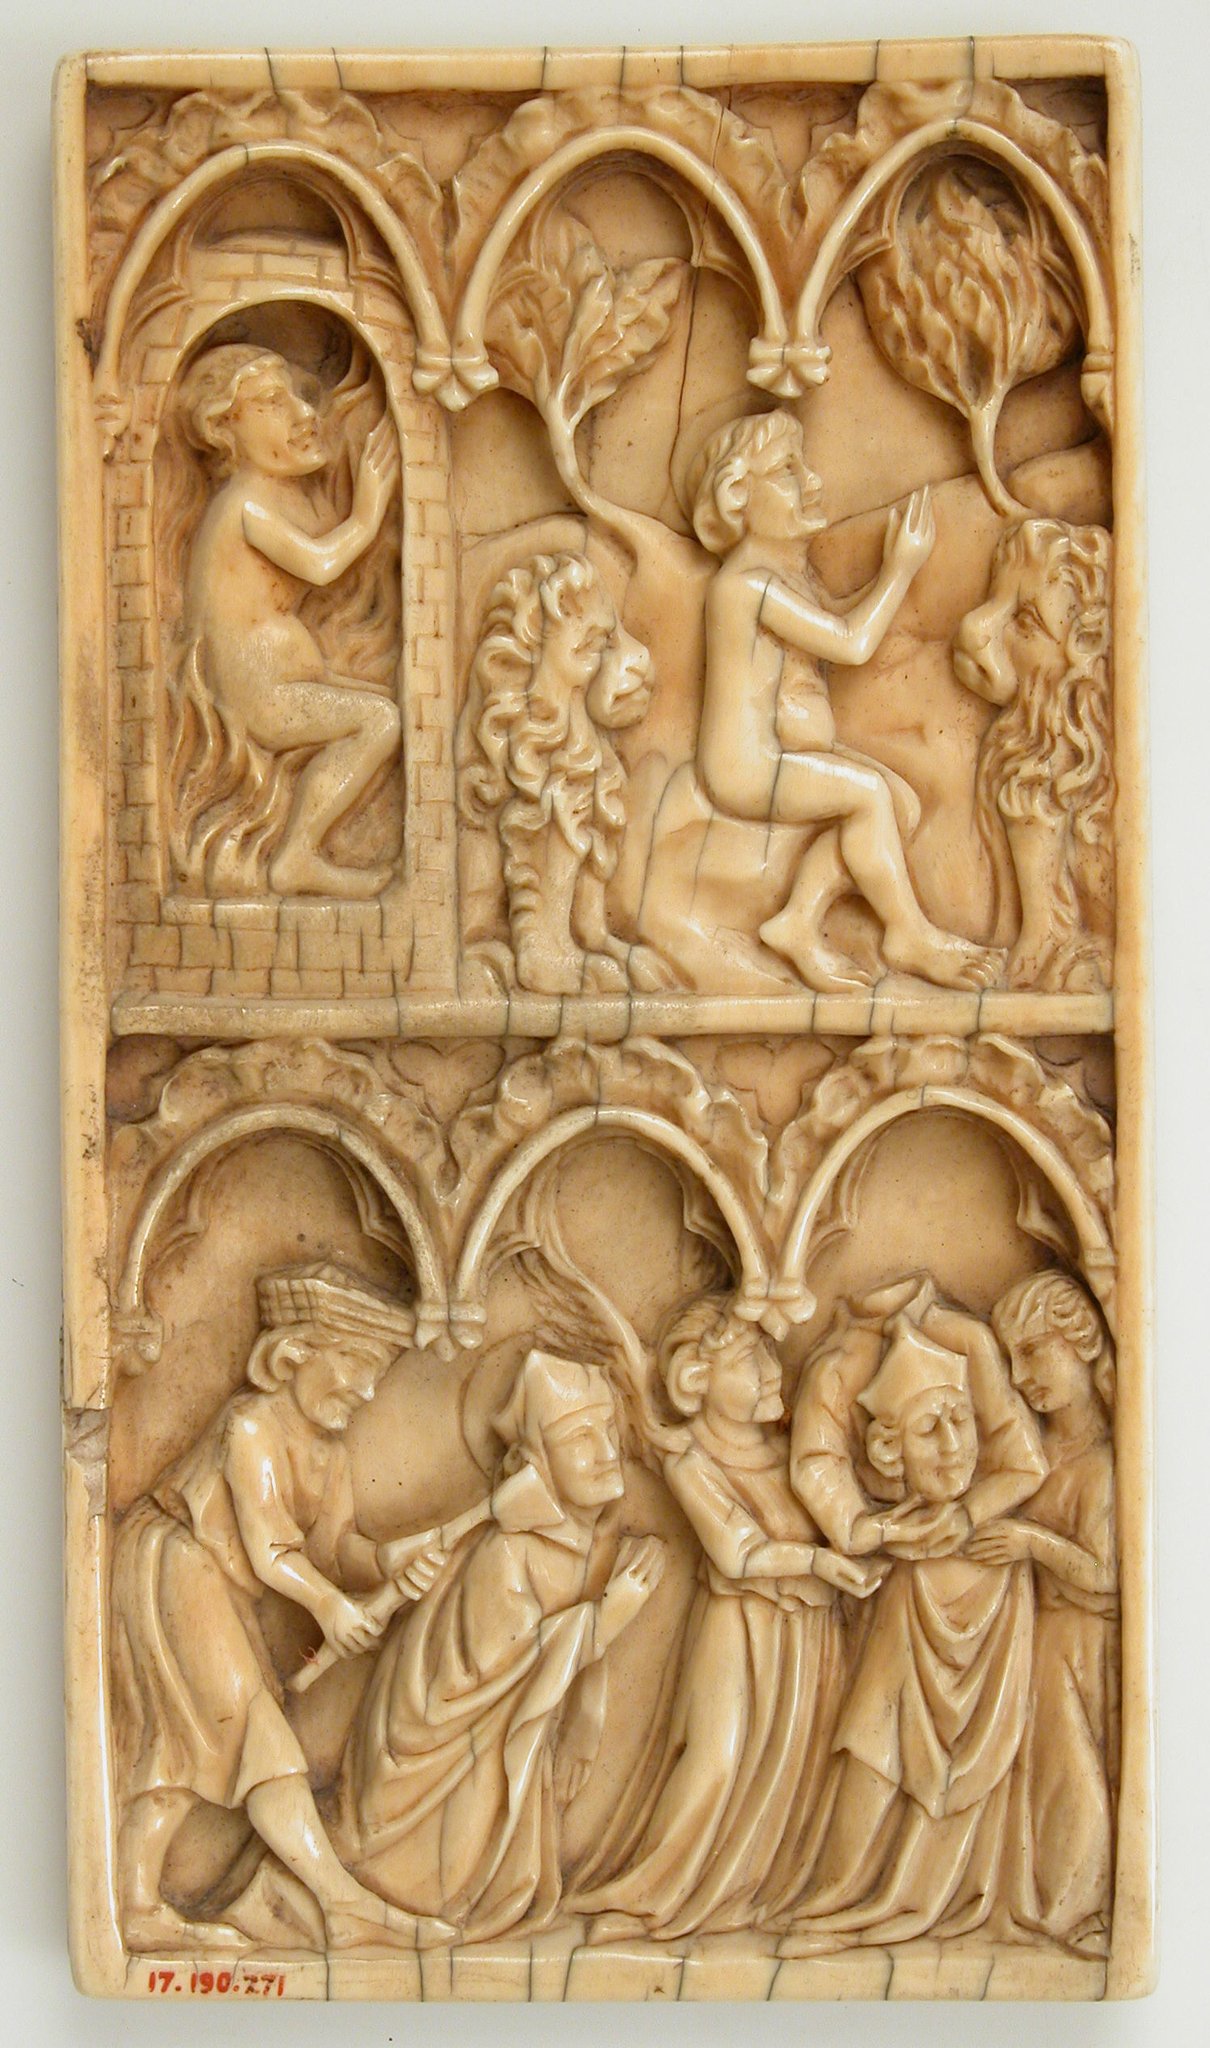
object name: panel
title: Panel with Scenes featuring Unknown Saints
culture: european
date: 1801-1900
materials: ivory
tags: men,lions